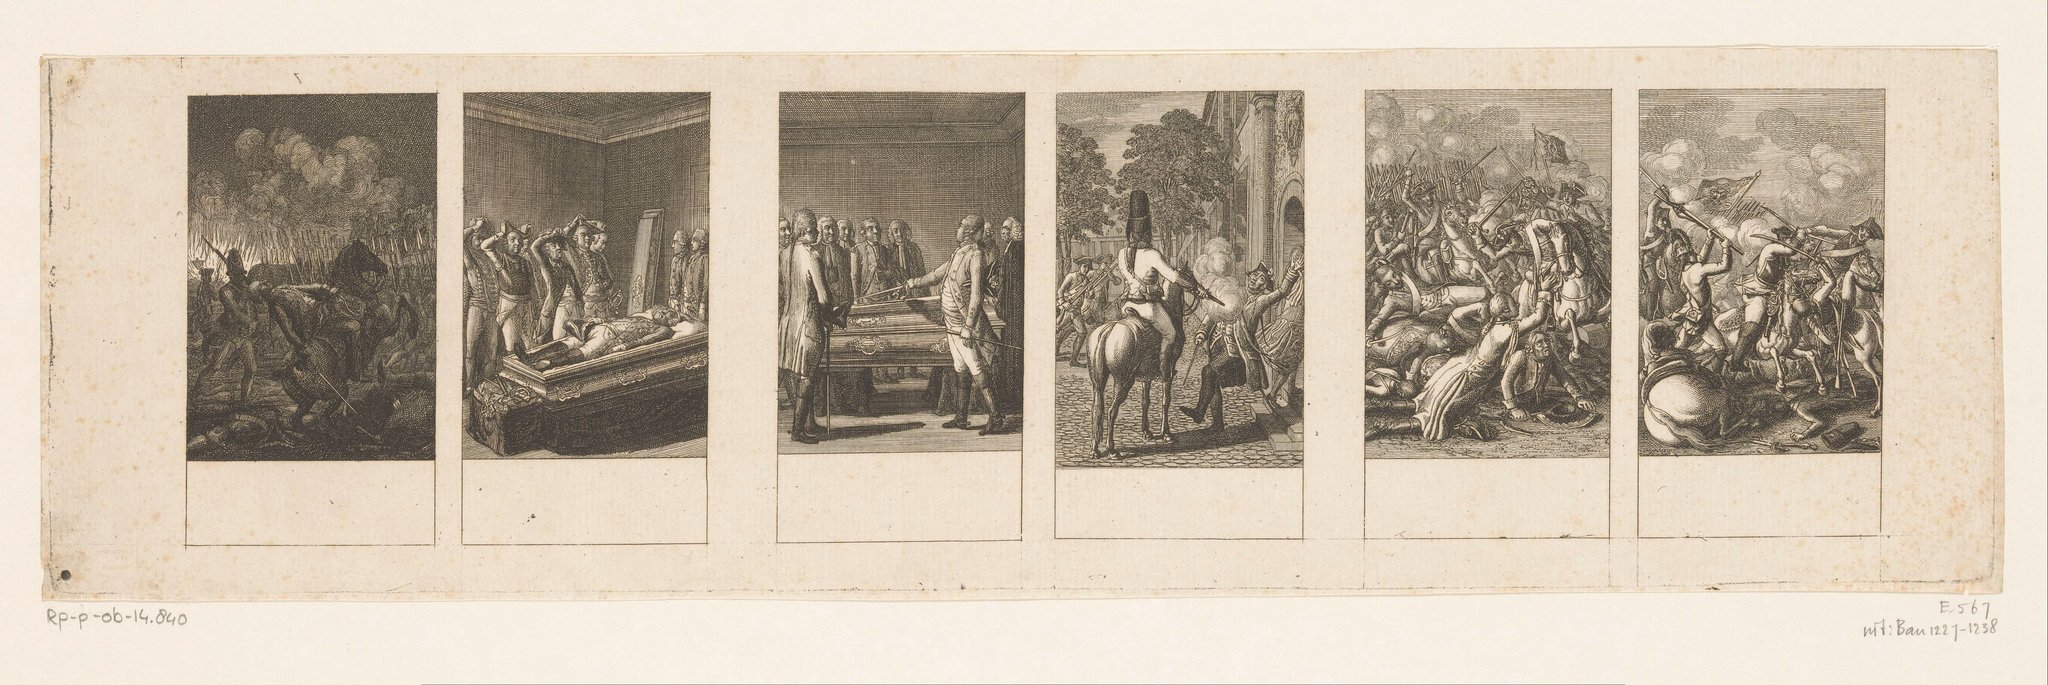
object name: print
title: Zes voorstellingen met Brandenburgse oorlogsscènes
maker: daniel nikolaus chodowiecki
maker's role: draughtsman, print maker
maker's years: 1726-1801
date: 1786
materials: paper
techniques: etching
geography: berlin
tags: placing the corpse in the coffin, commander-in-chief, general, marshal, battle, firearms, war, death of human being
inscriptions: collector's mark: Lugt 2228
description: Latere staat gebruikt voor: Genealogischer Militairischer Calender auf das Jahr 1787 (...). S.l.s.n.s.a.